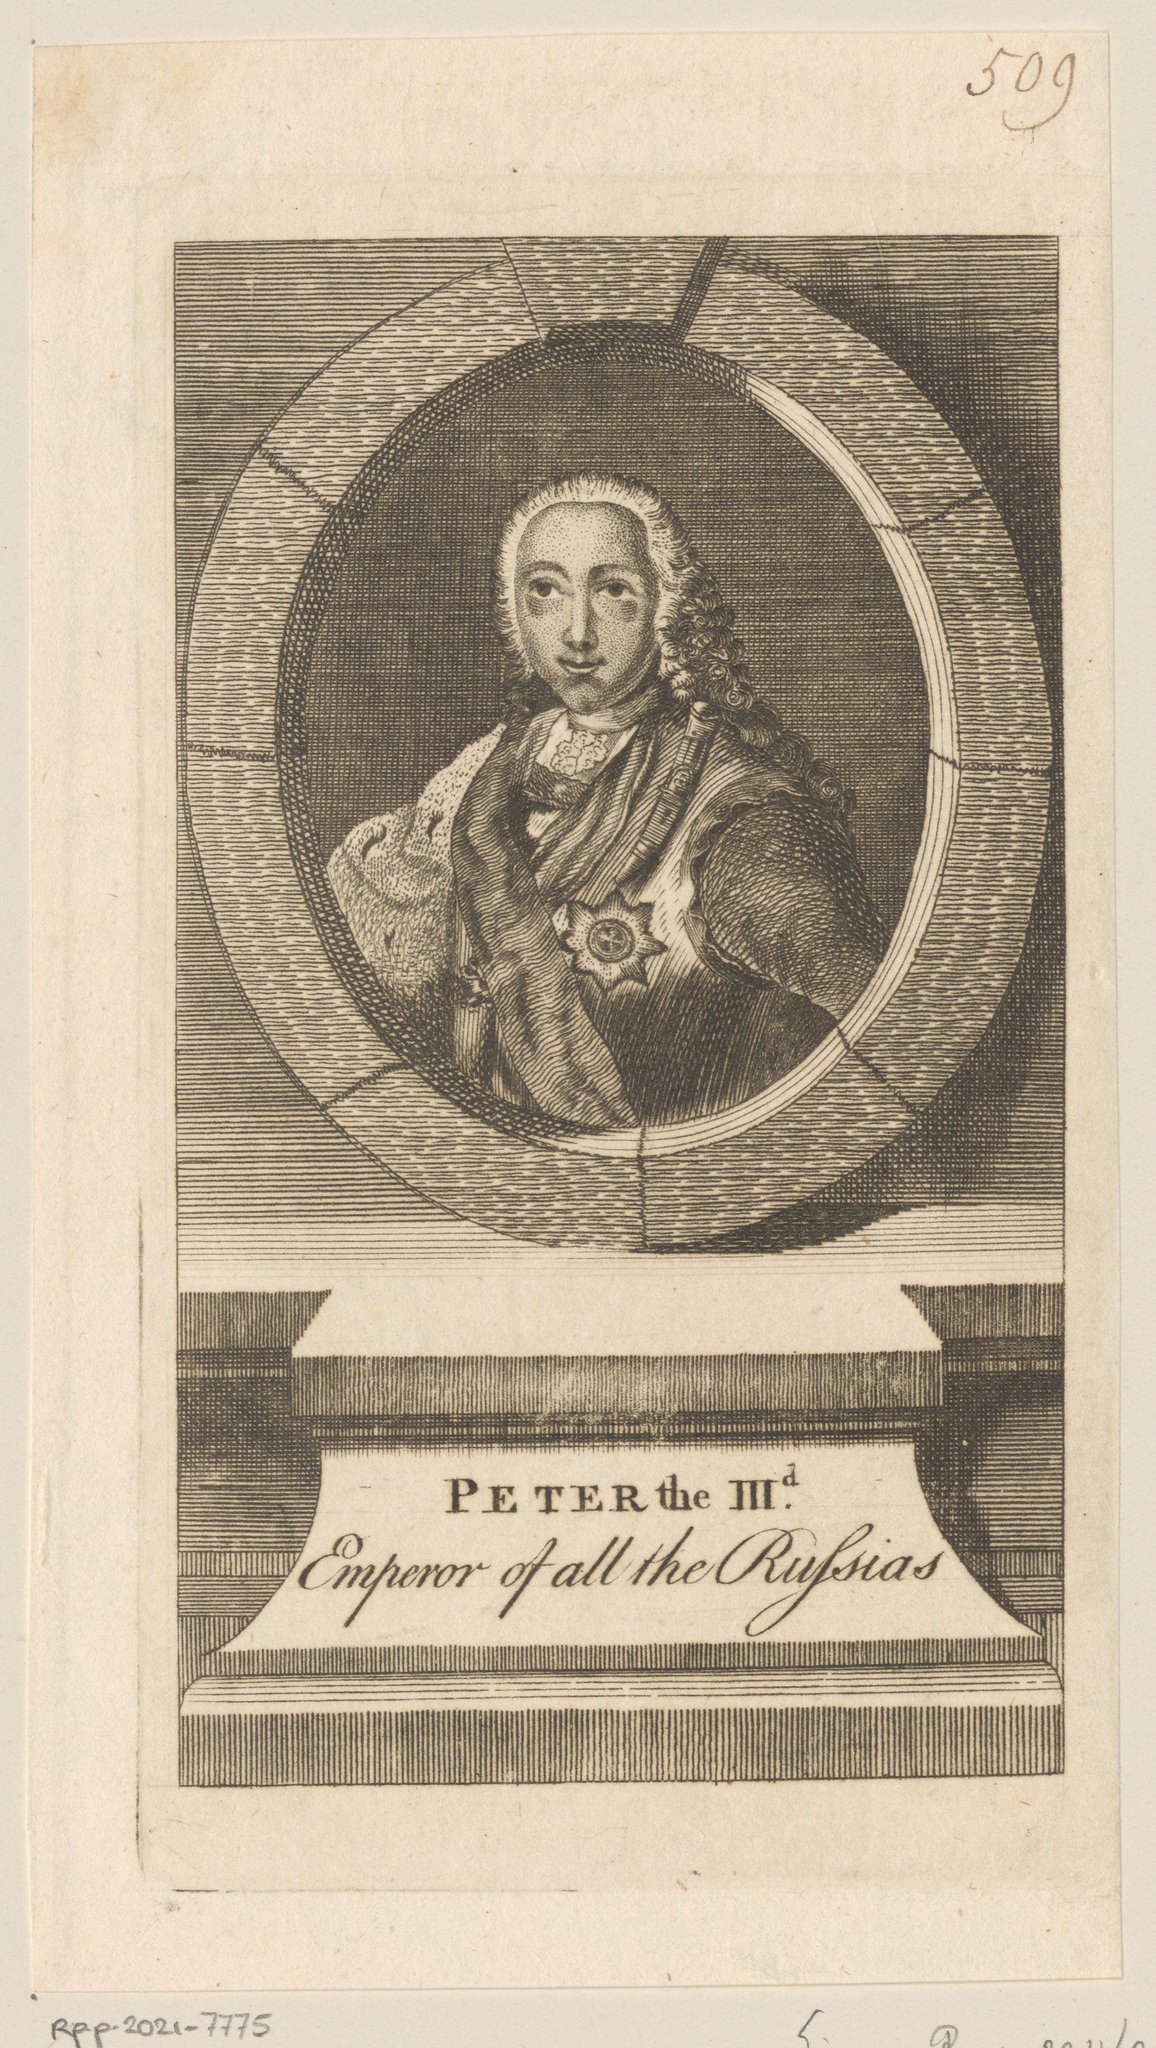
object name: print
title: Portret van Peter III, tsaar van Rusland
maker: Anonymous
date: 1762-1799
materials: paper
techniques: engraving, etching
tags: adult man, historical persons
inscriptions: inscription: ‘509’